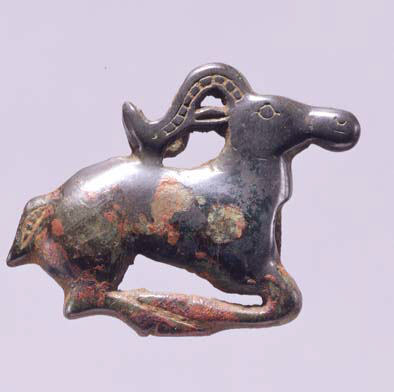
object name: harness ornament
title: Harness Ornament in the Shape of Gazelle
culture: chinese, northeast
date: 600-401 BCE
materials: bronze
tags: animals